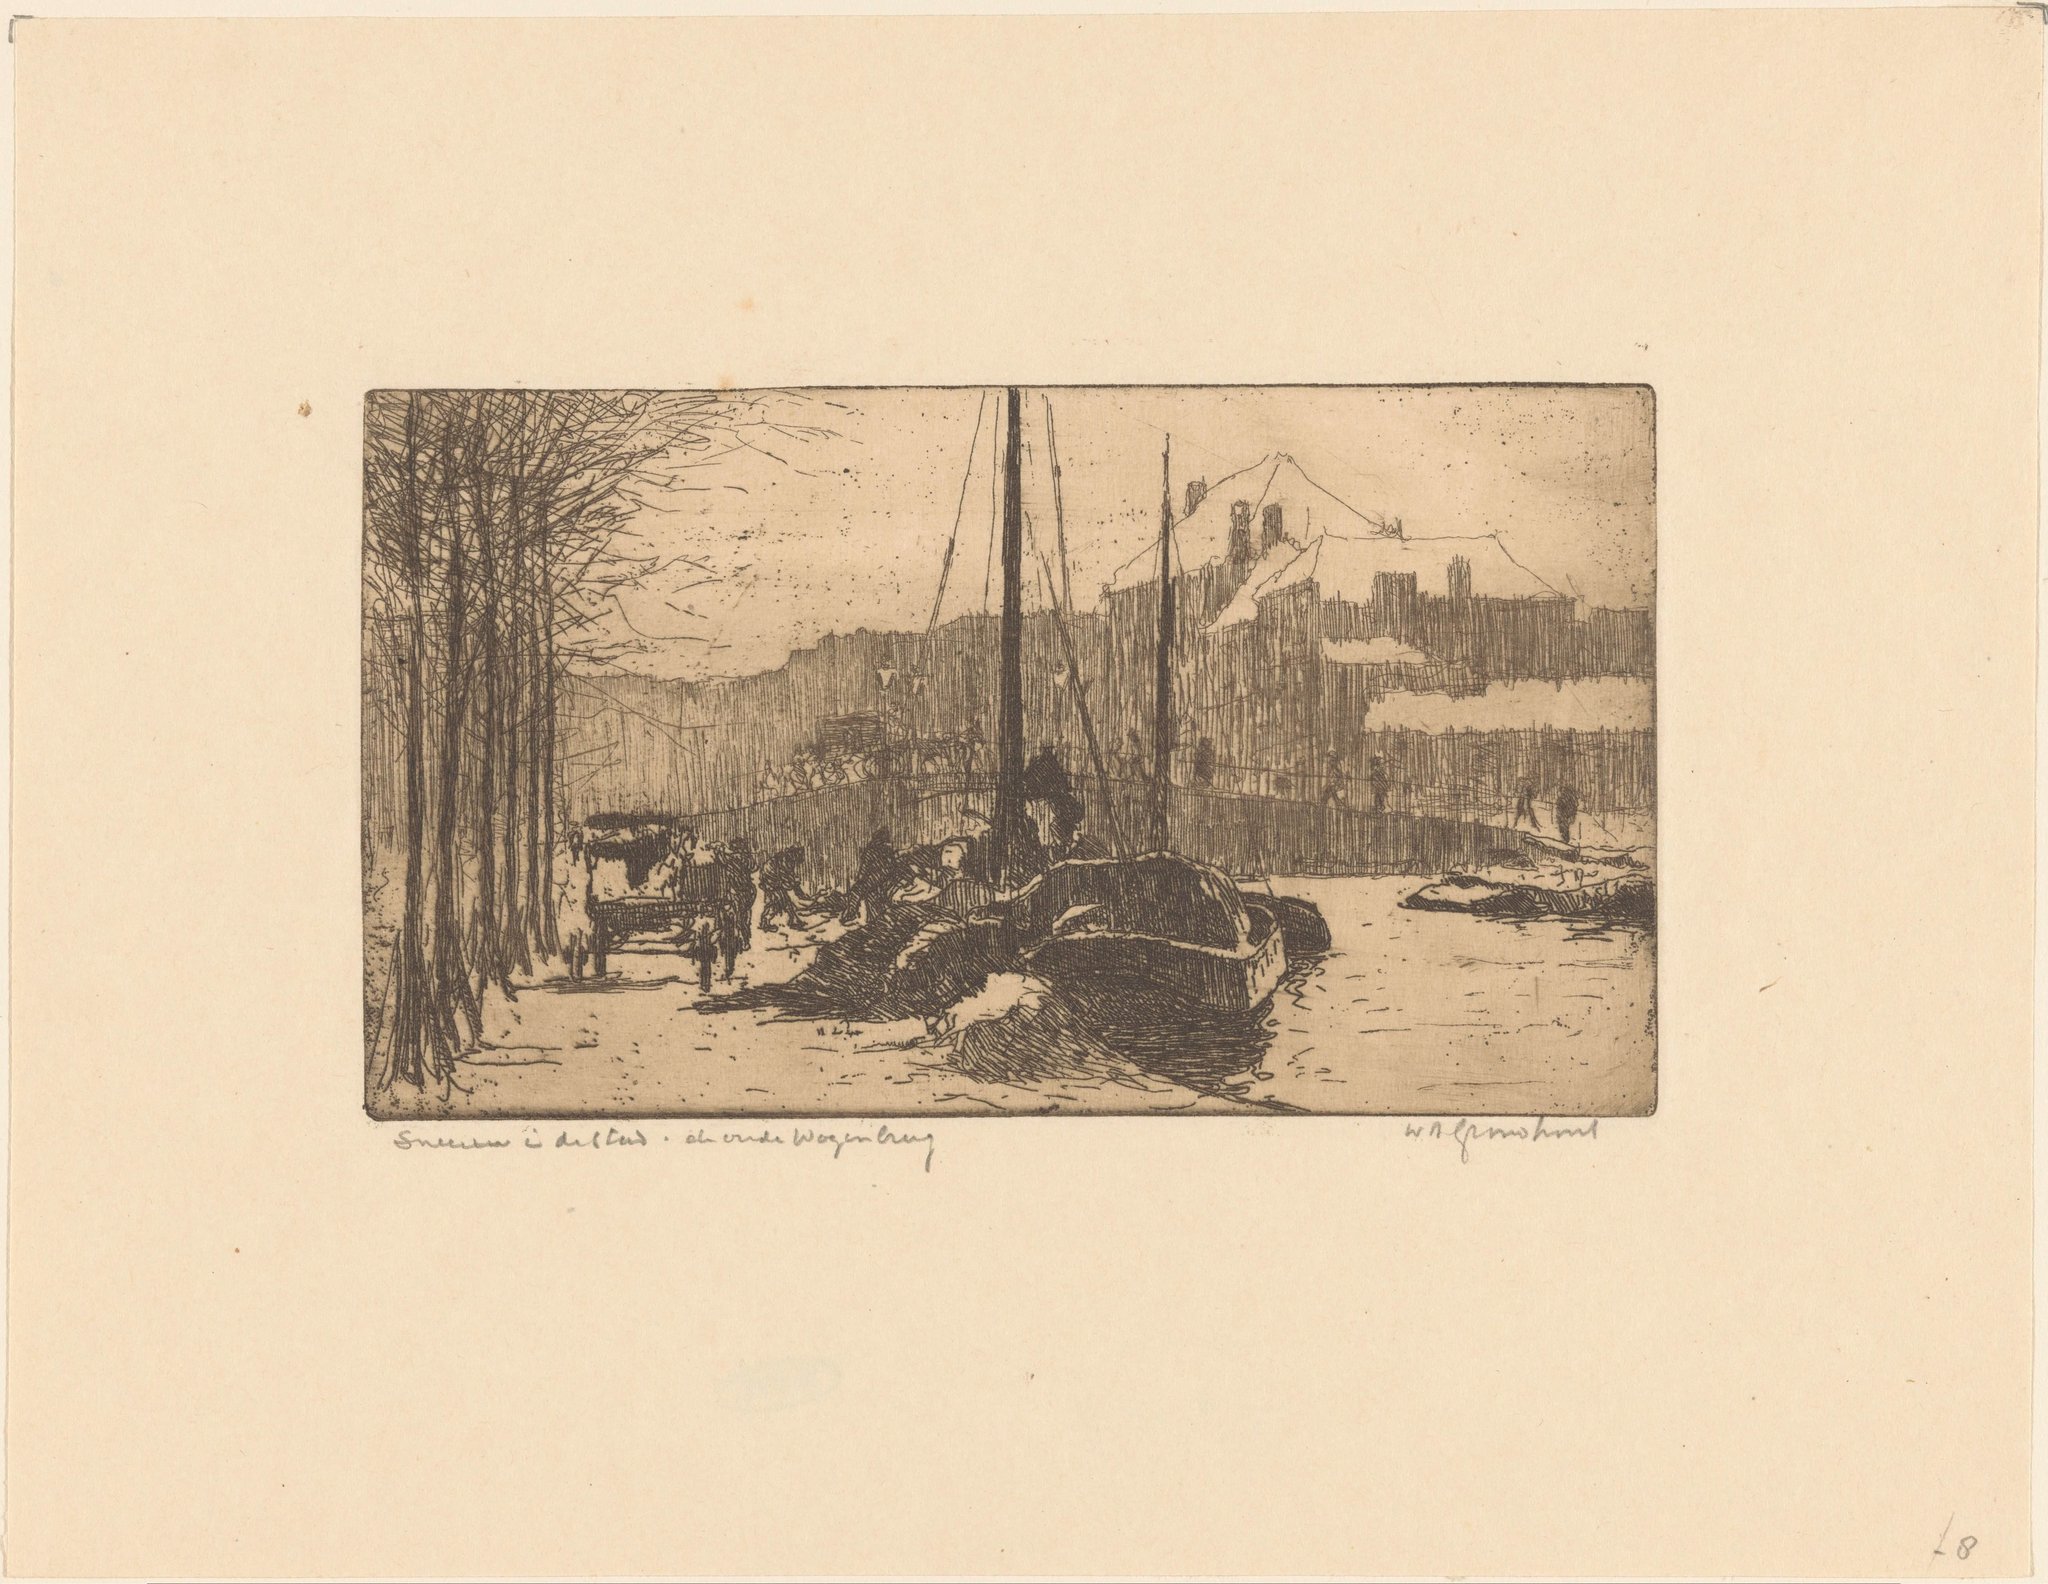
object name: print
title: Sneeuw in de stad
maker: willem adrianus grondhout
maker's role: draughtsman, painter, print maker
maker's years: 1878-1934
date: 1888-1934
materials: paper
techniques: etching, intaglio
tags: ships (in general), snow, bridge in city across river, canal, etc.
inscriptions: collector's mark: Lugt 2228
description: Afgemeerde schuiten aan een besneeuwde kade in Den Haag. Op de achtergrond de Wagenbrug.